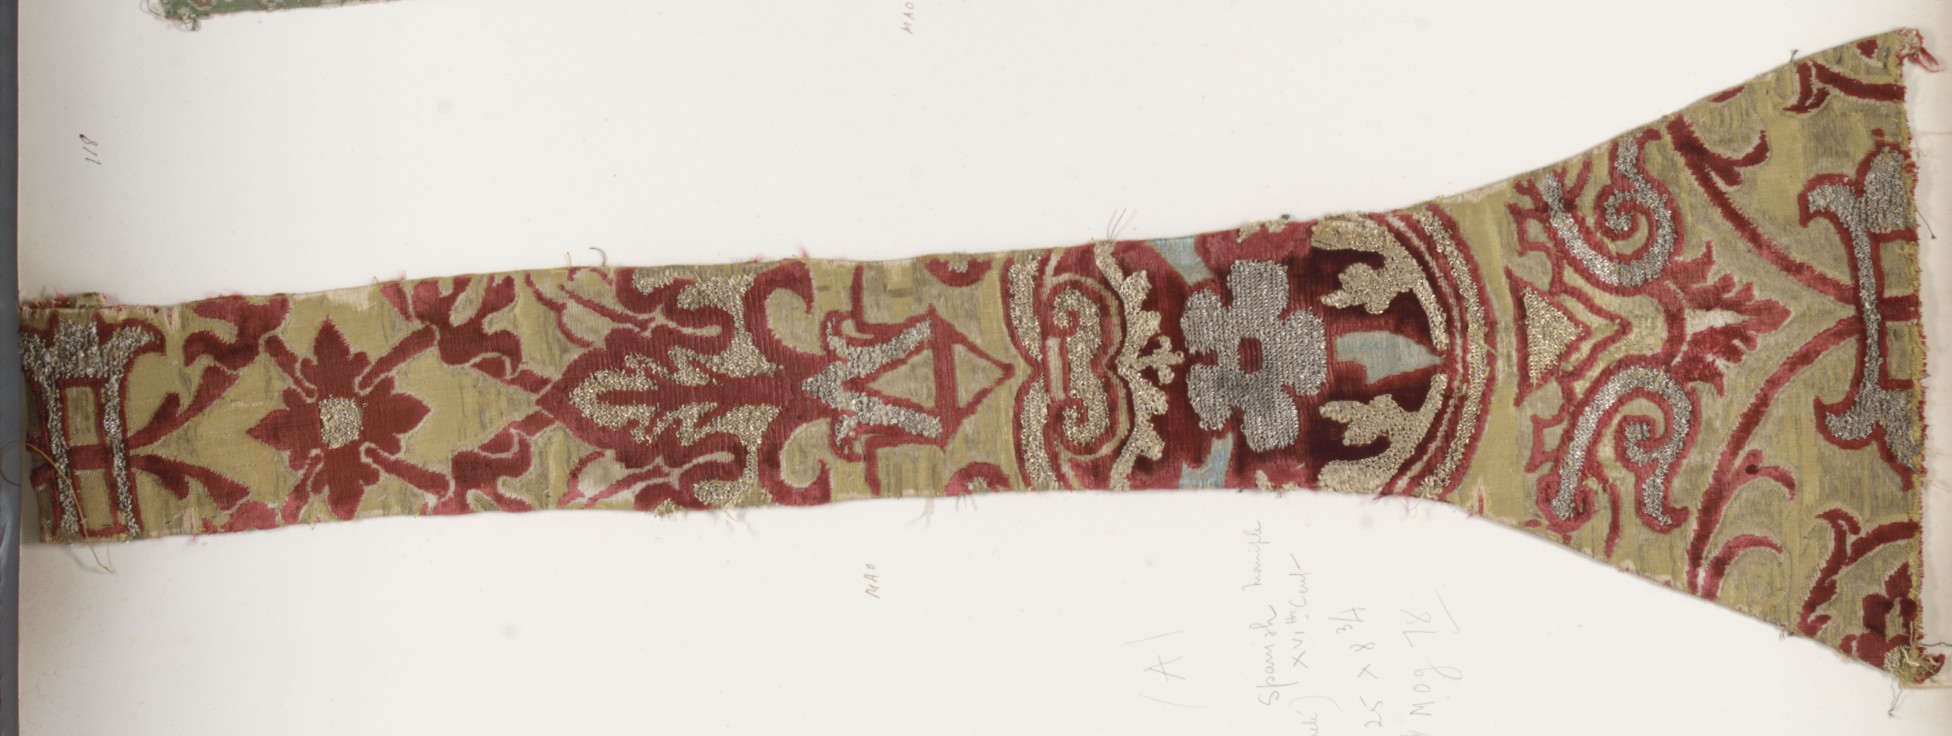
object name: fragment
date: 1501-1600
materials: metal thread, silk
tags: flowers